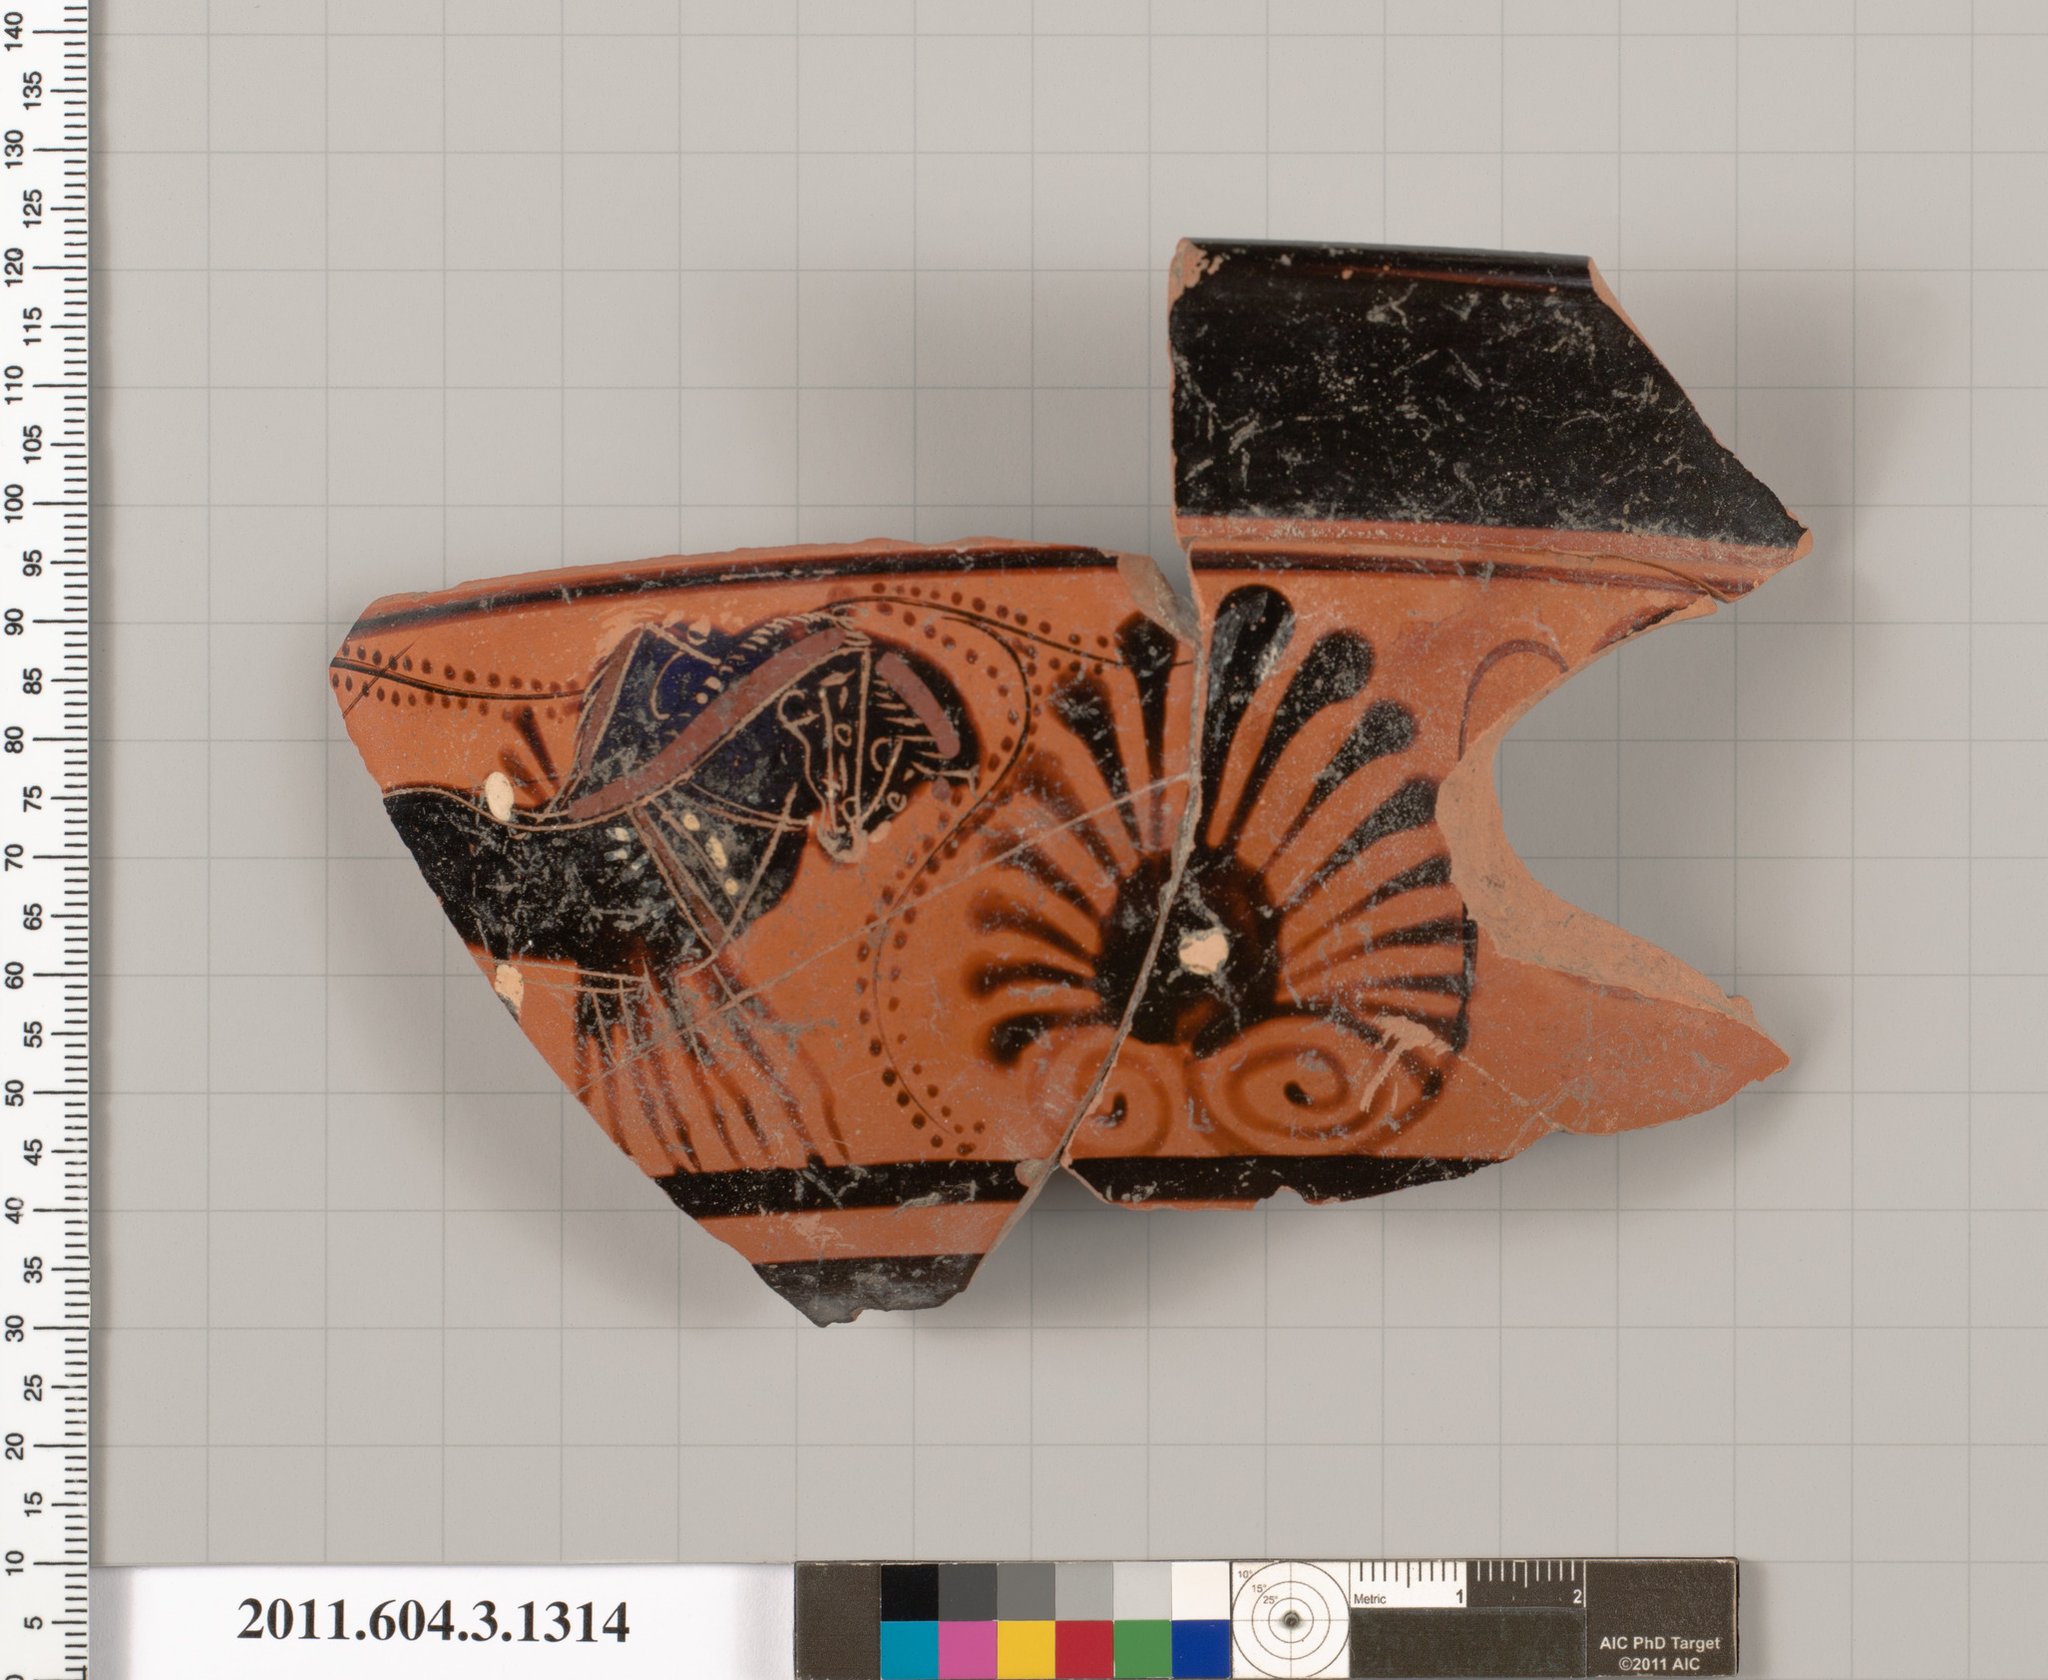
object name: skyphos fragment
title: Terracotta rim fragment of a skyphos (deep drinking cup)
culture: greek, attic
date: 490-480 BCE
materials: terracotta